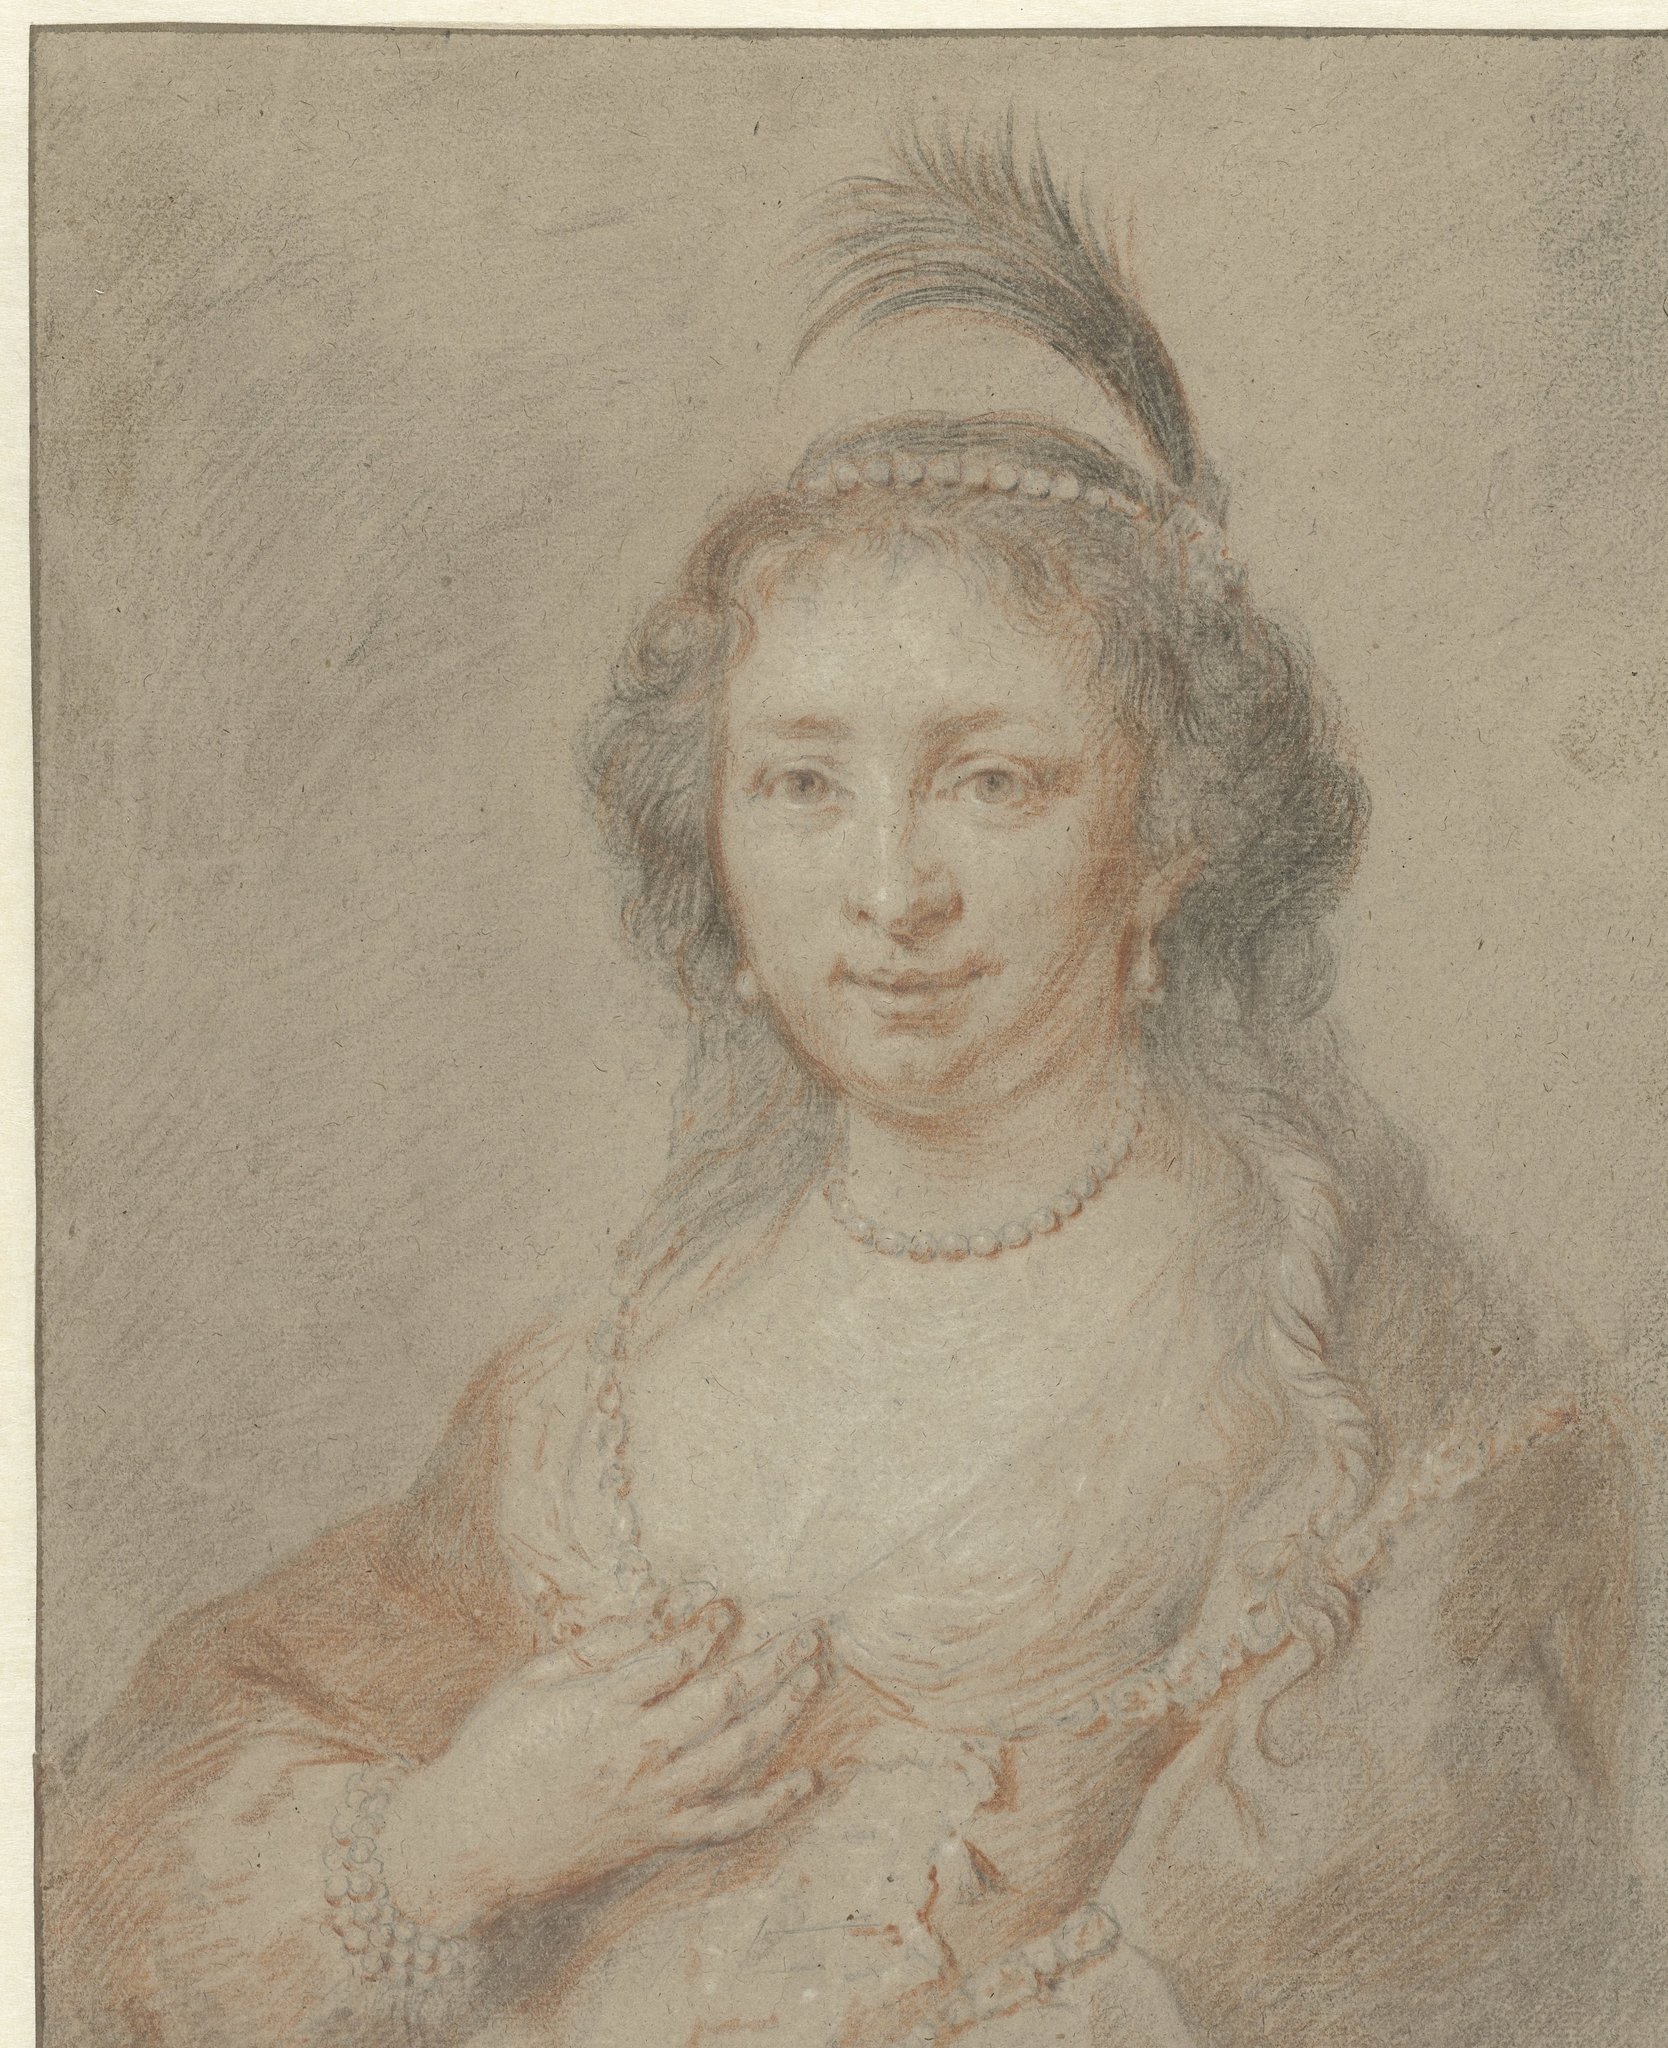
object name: drawing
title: Portret van Sara van Baerle, echtgenote van Philips van Dorp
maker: jan maurits quinkhard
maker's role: draughtsman, painter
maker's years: 1688-1772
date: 1747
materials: chalk, paper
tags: historical persons